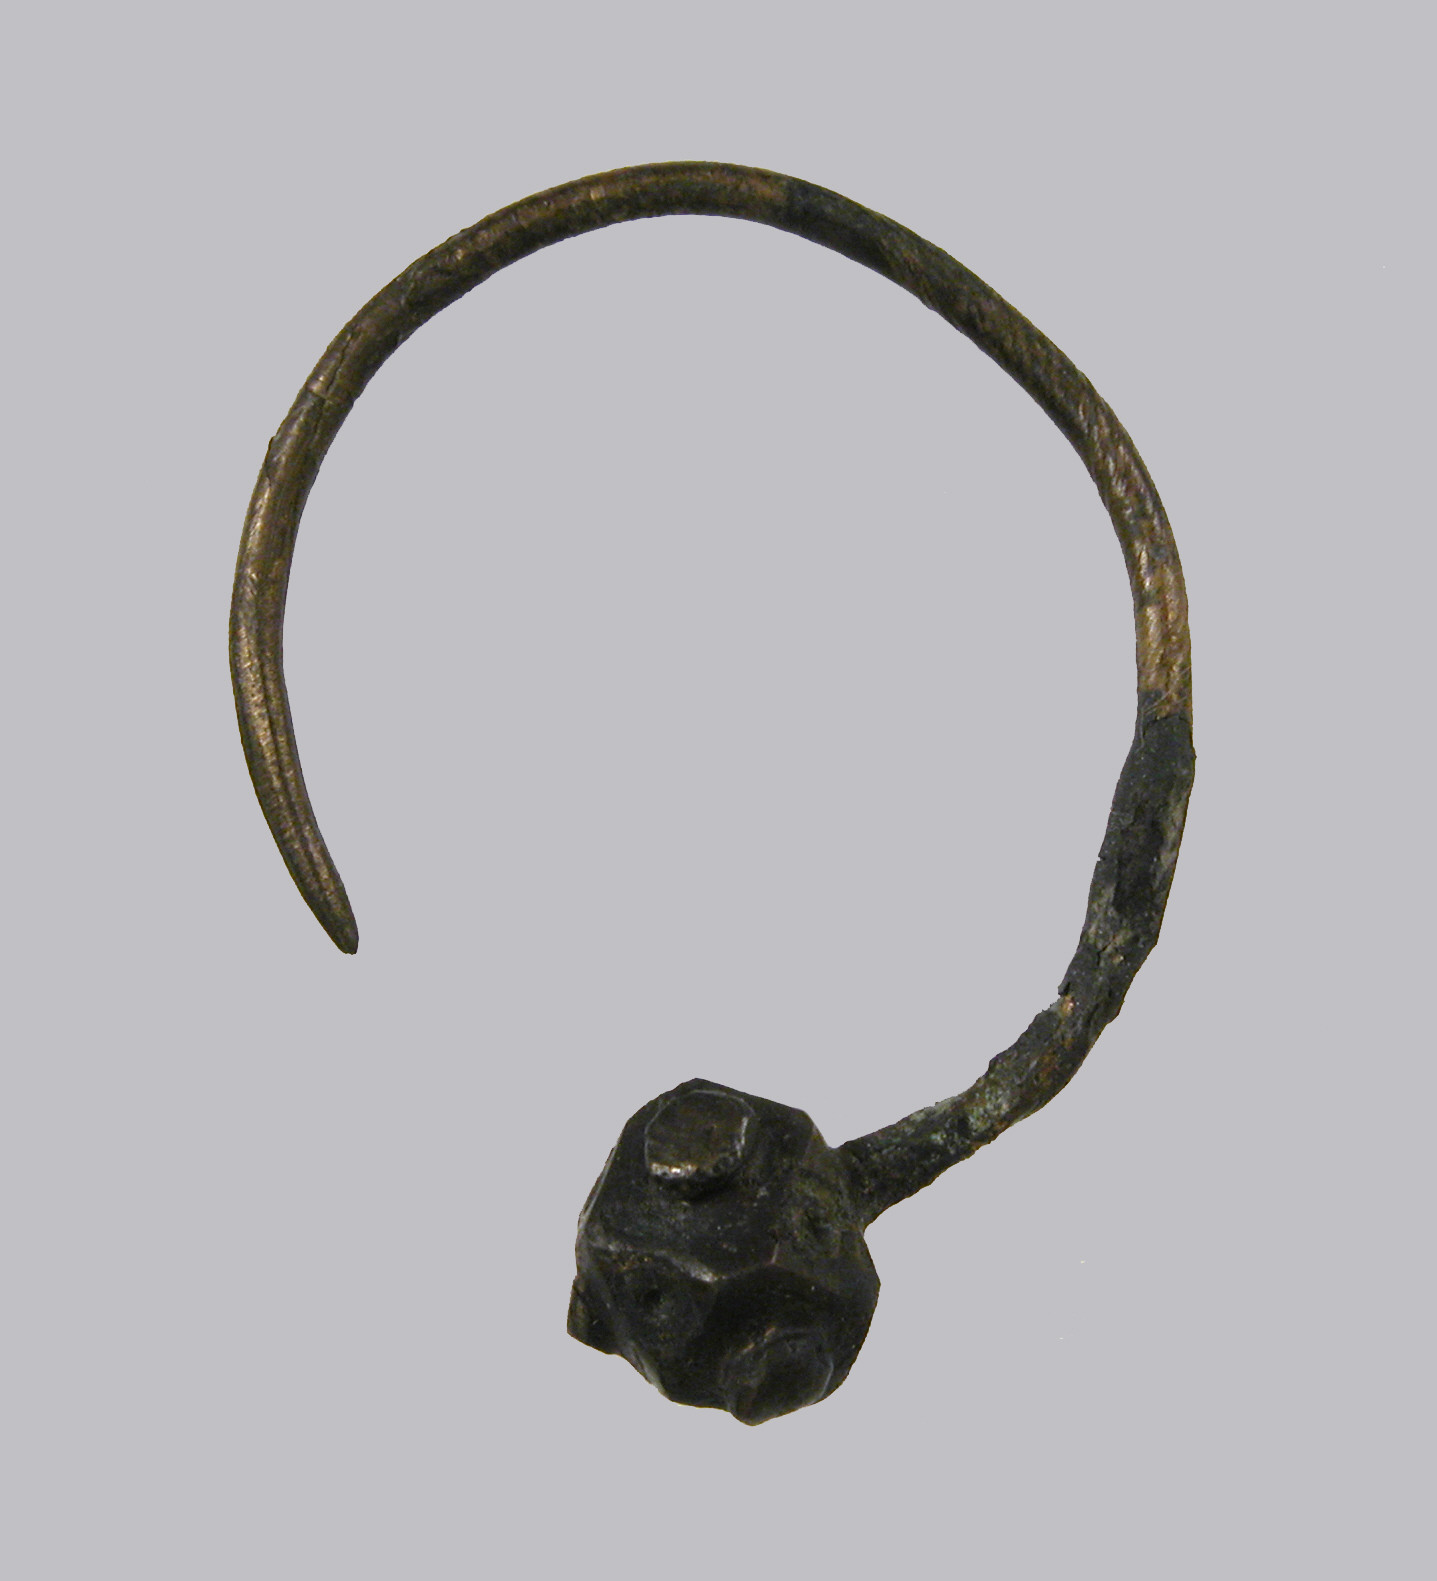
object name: earring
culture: frankish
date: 501-700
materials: copper alloy, gilt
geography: northern france